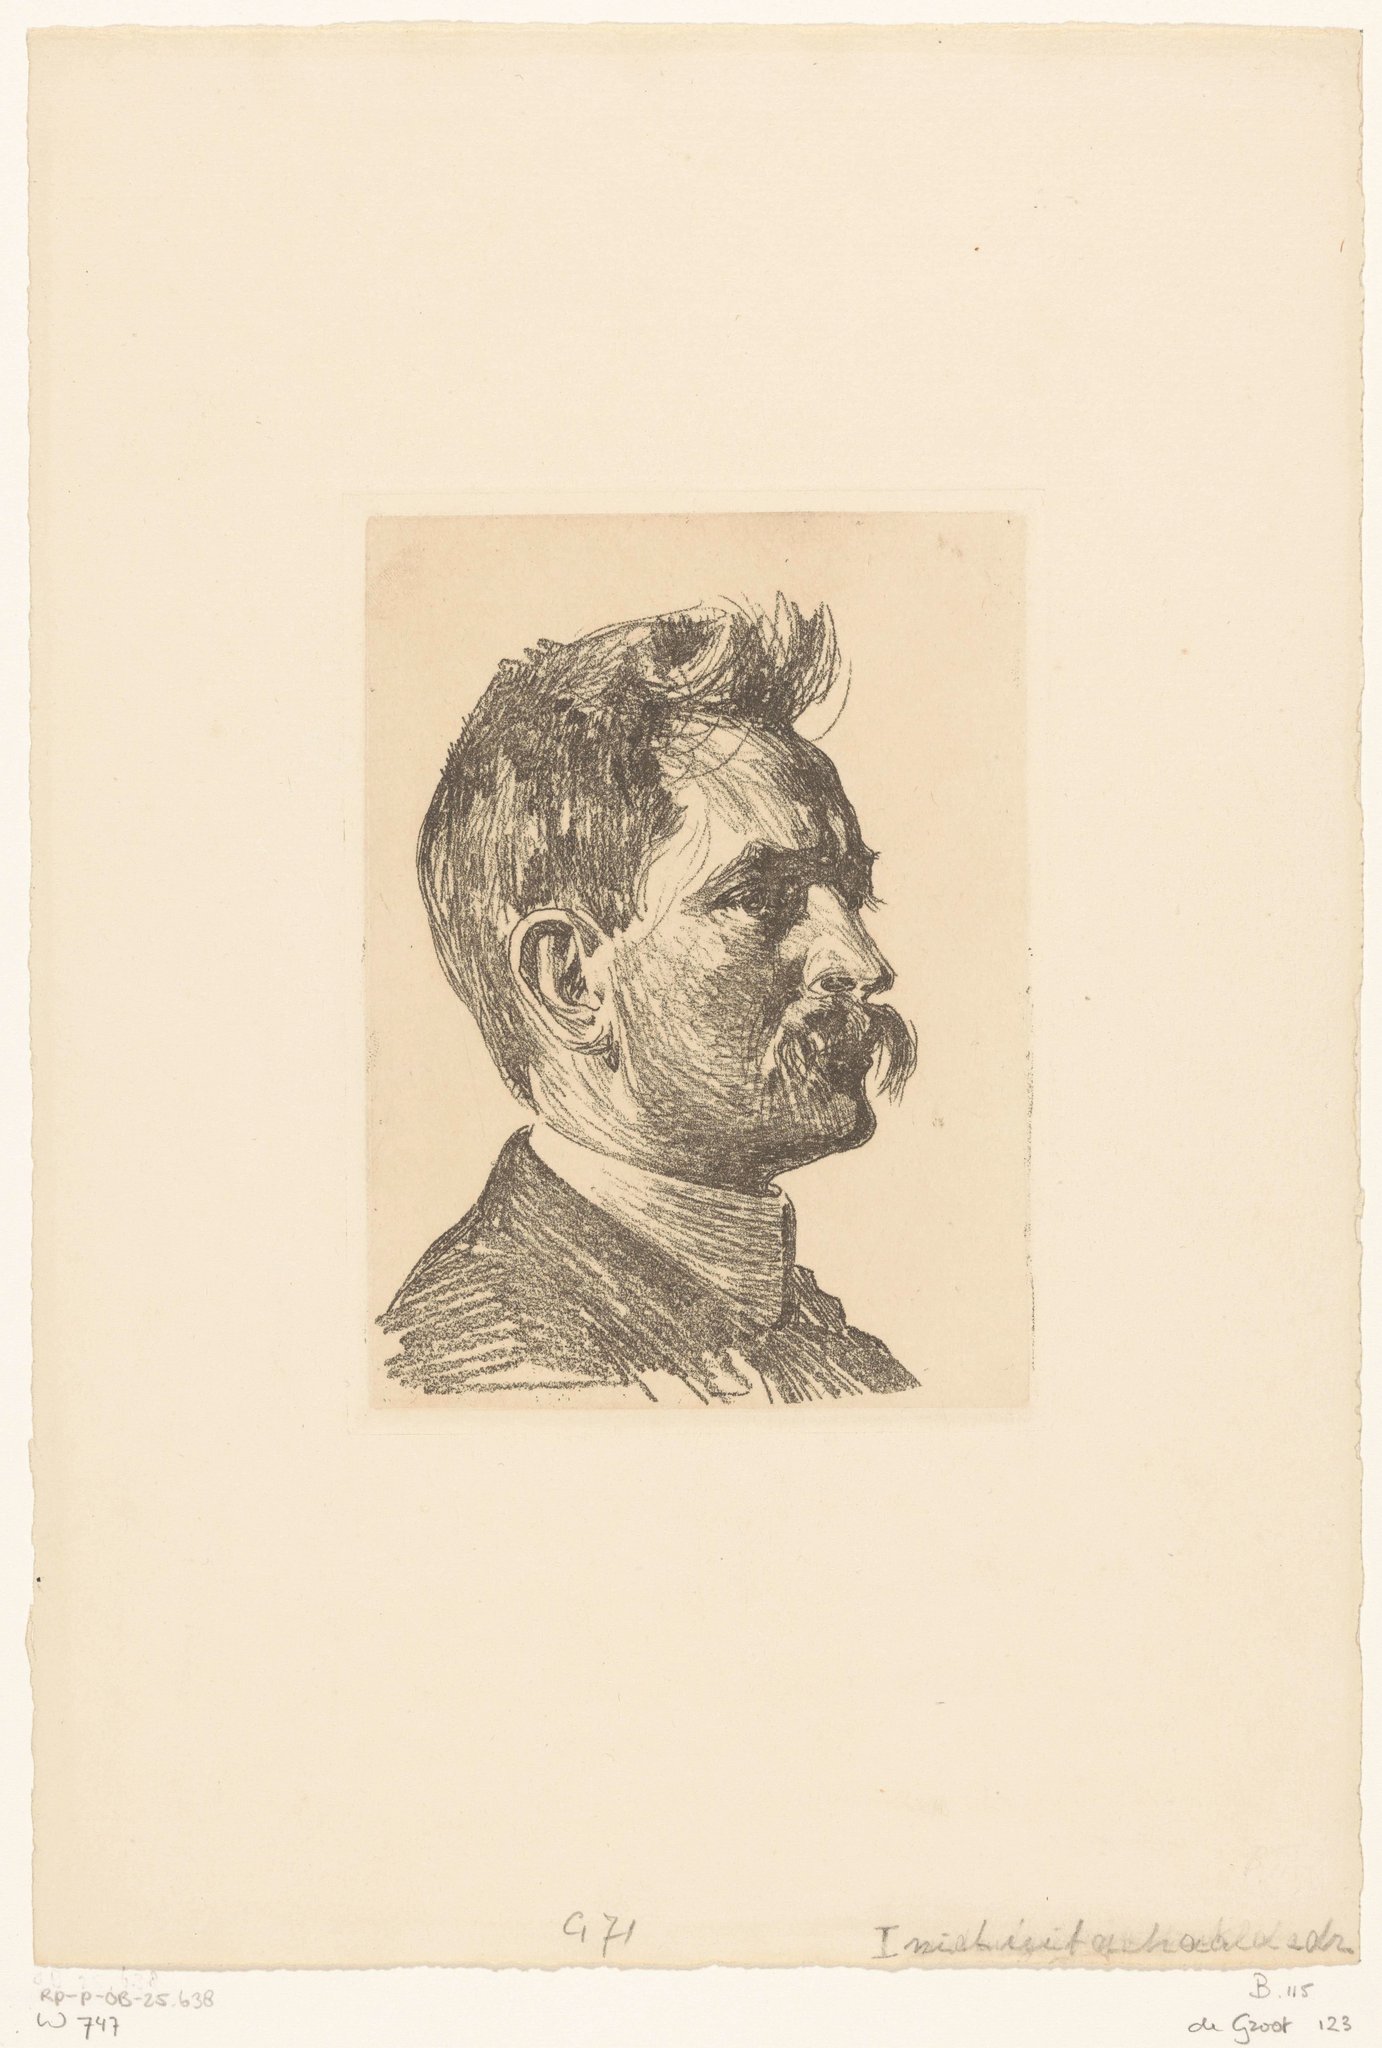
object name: print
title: Portret van Jan Hofker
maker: willem witsen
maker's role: draughtsman, painter, print maker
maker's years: 1860-1923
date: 1905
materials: paper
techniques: soft ground etching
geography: amsterdam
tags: portrait of a writer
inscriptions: watermark, inscription: ‘I niet uitgehaalde dr.’